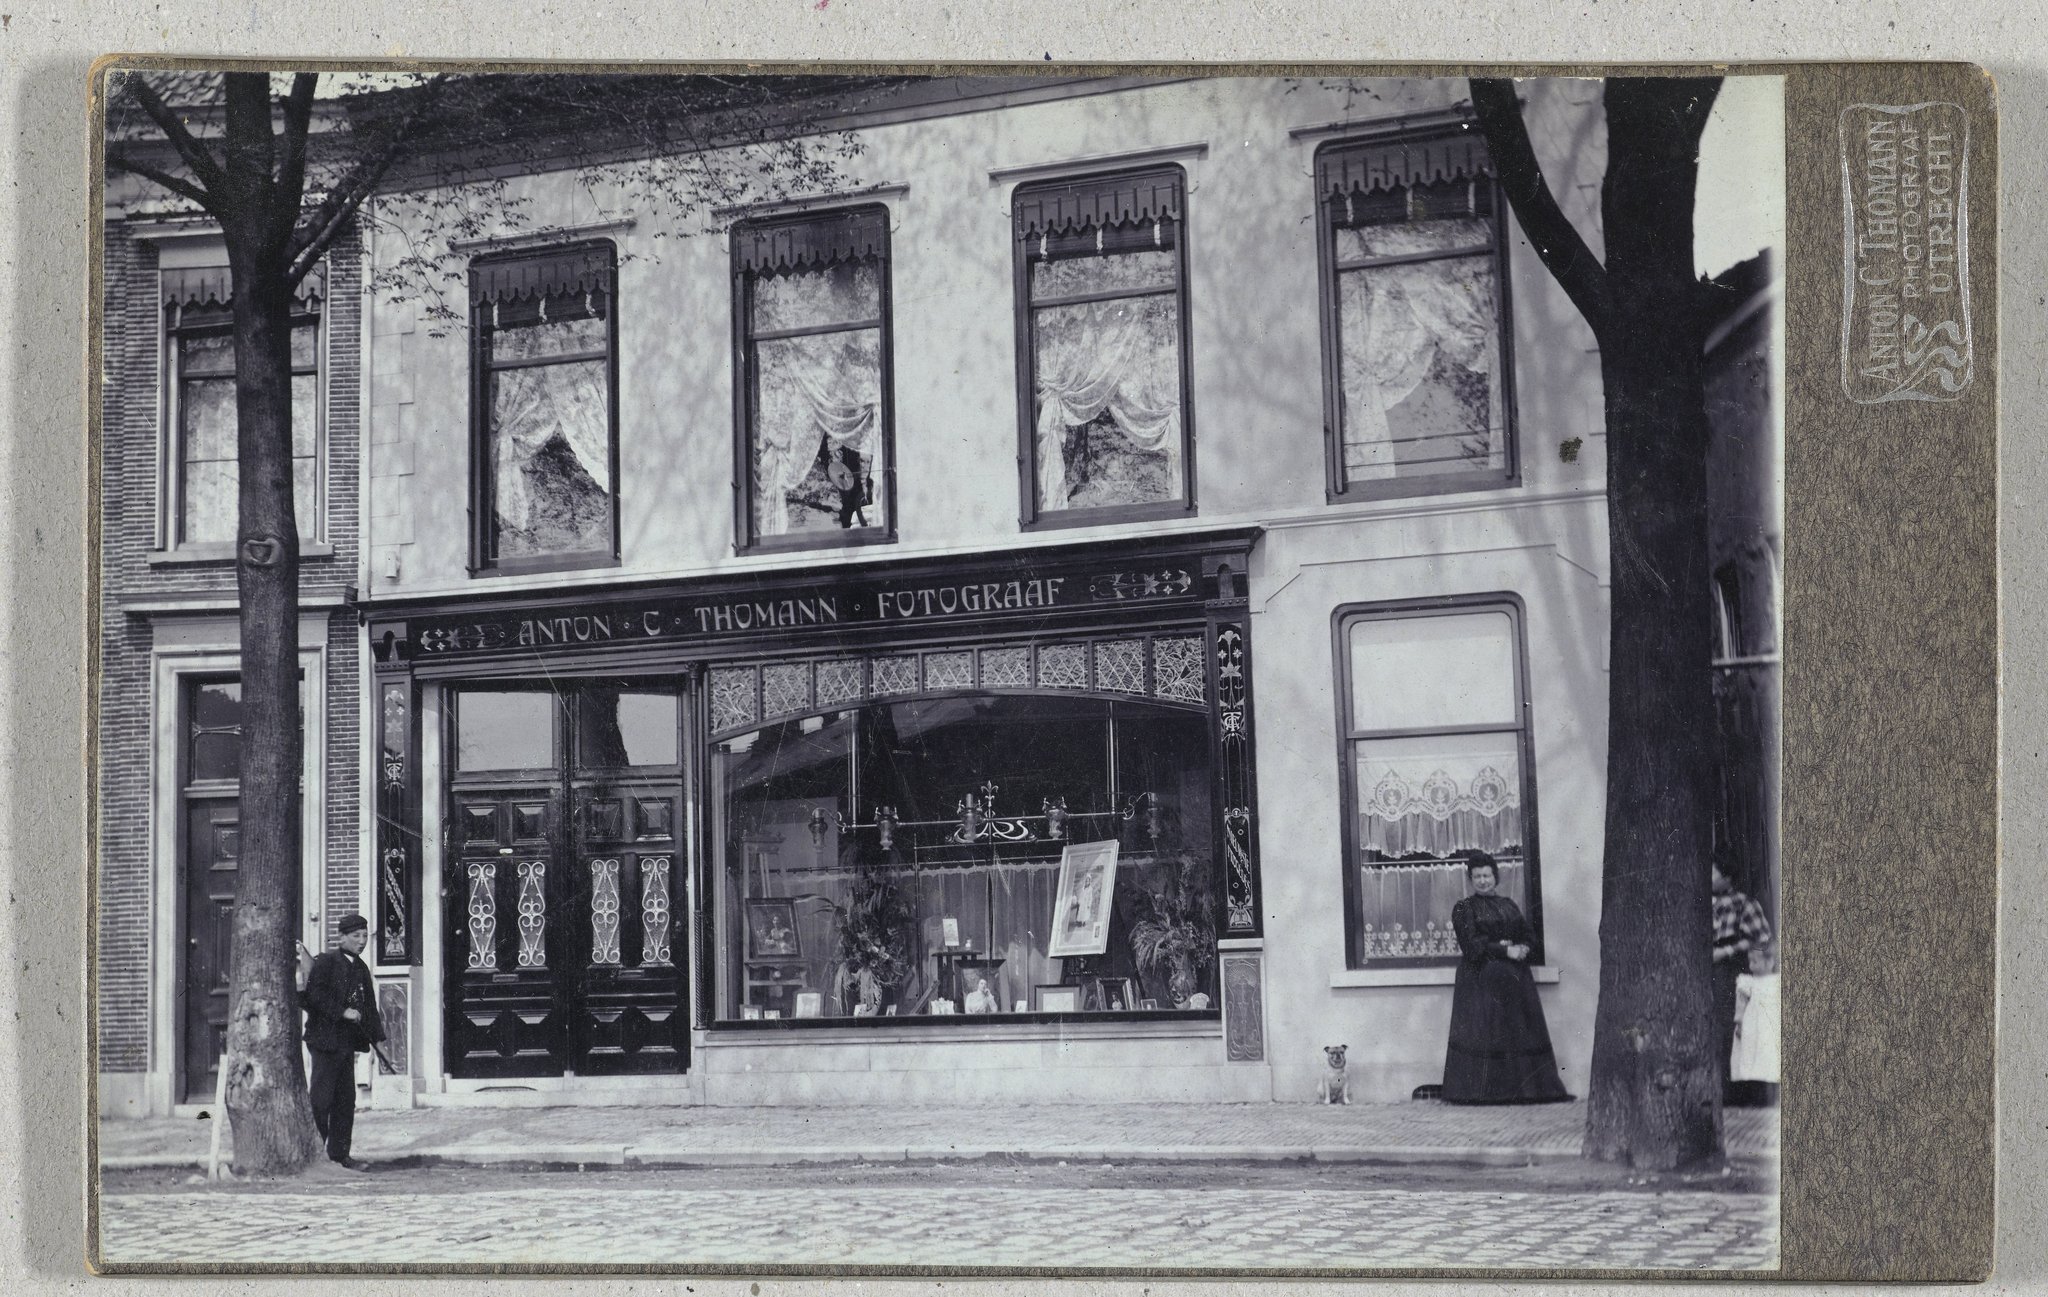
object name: photograph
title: Exterieur van het foto-atelier van A.C. (Anton) Thomann, Wittevrouwensingel 91, Utrecht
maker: anton cornelis thomann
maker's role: fotograaf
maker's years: 1873-1946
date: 1902-1910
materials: cardboard, paper, photographic support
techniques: gelatin silver print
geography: utrecht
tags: shop-window, show-window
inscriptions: inscription: ‘ANTON C. THOMANN / PHOTOGRAAF / UTRECHT’, inscription: ‘ANTON C. THOMANN / UTRECHT / WITTE VROUWE SINGEL 91, / 5e huis van af de gasfabriek. / ELECTRO-FOTOGRAFIE, / "EIGEN VINDING." / Onderscheidingen / BERLIJN 1900 / GRONINGEN 1901 / DüSSELDORF 1902 / BRüSSEL 1902 / Telefoon nummer 893.’